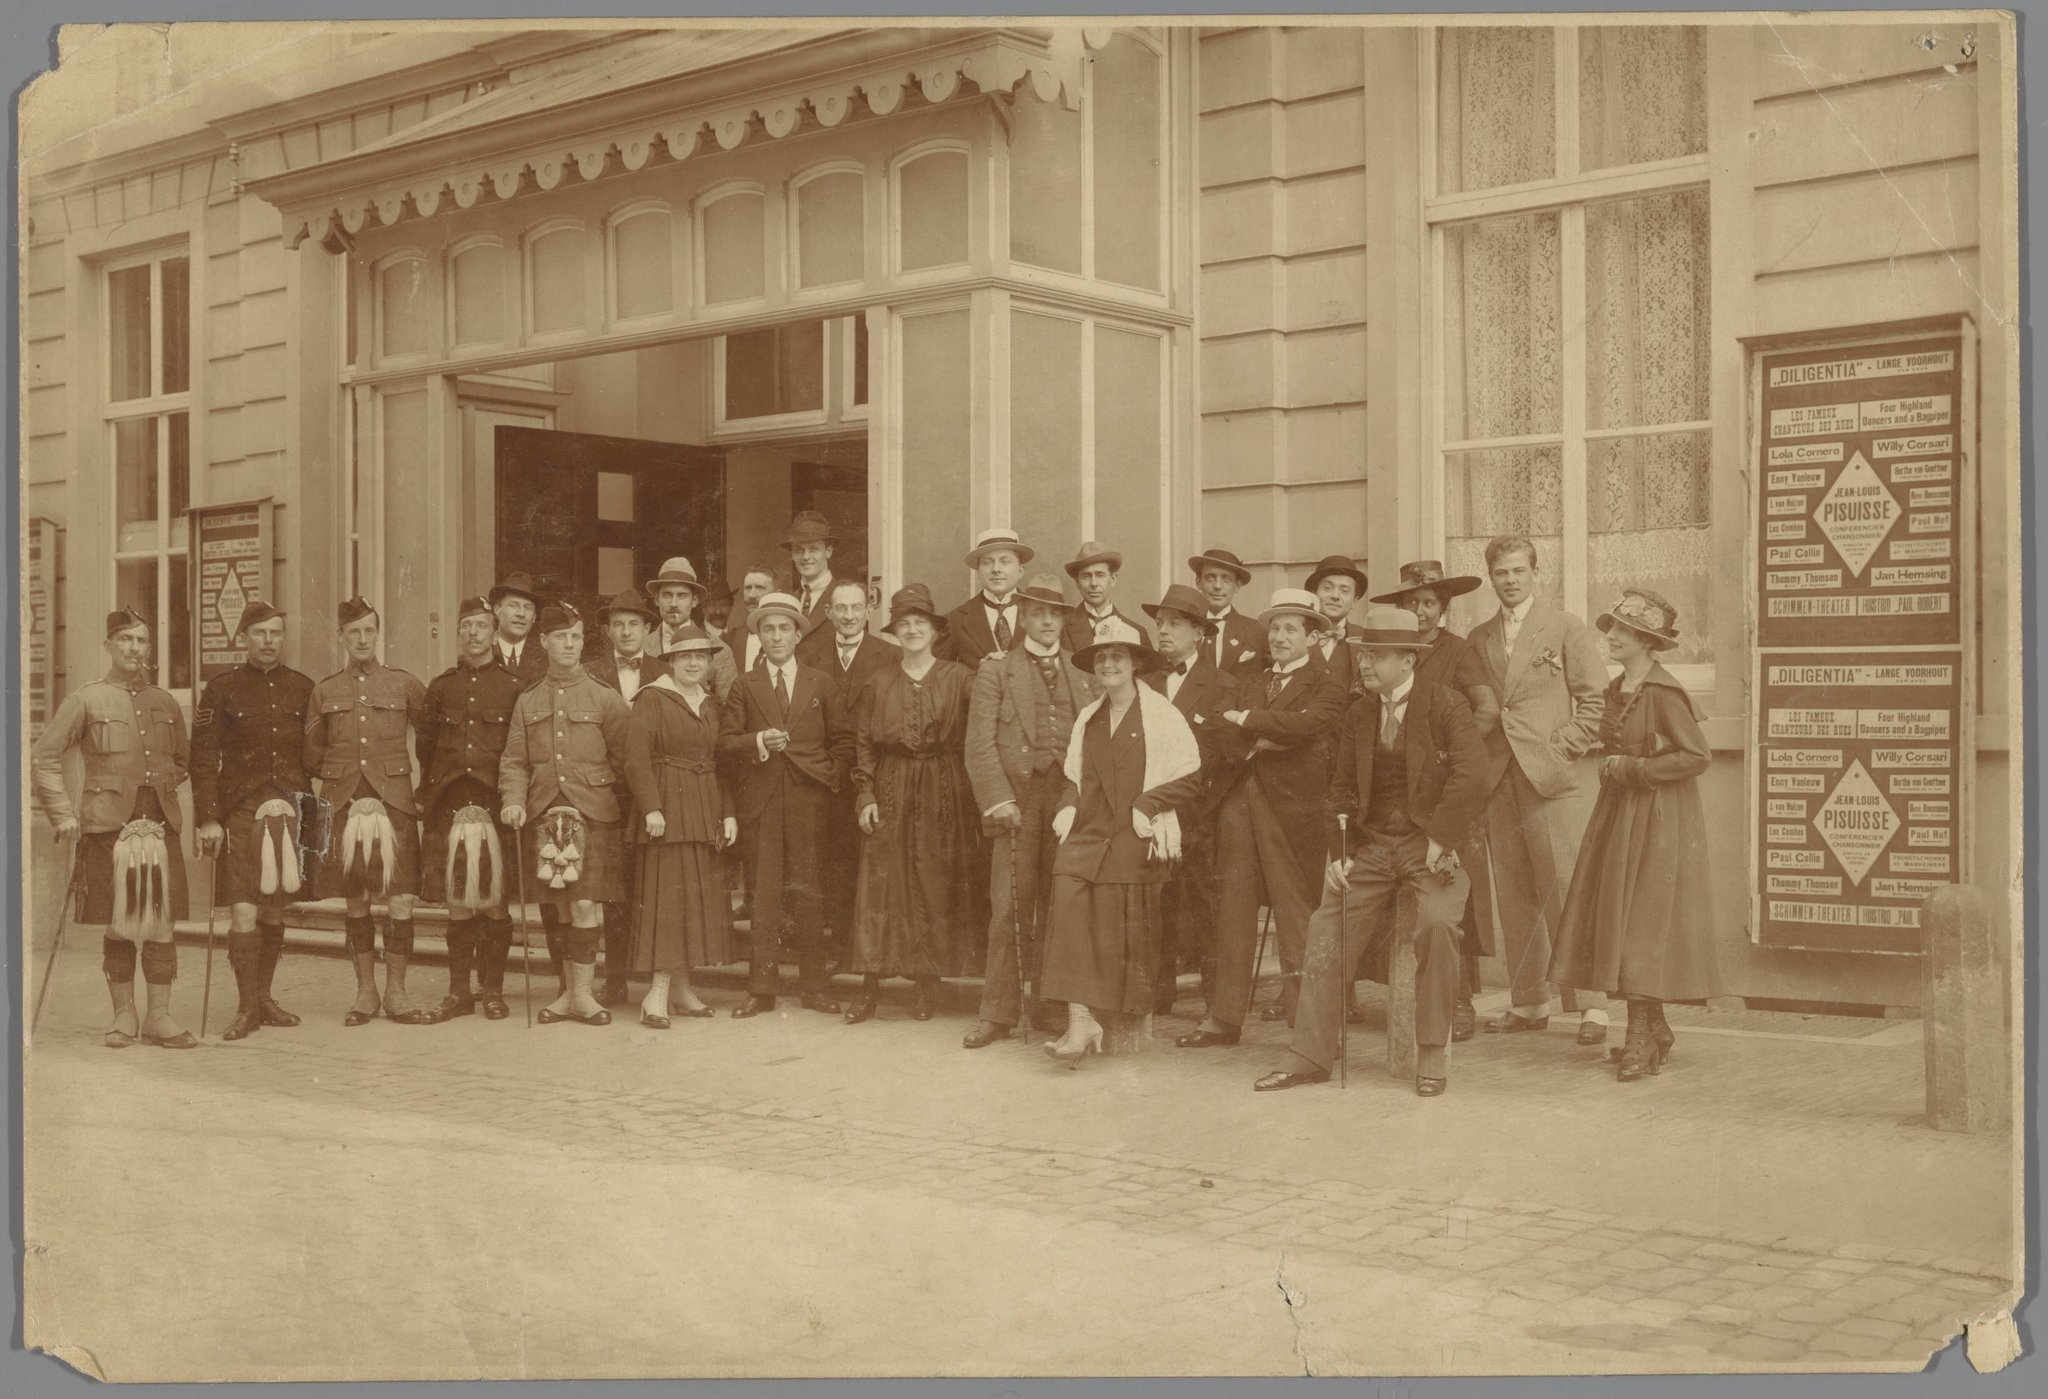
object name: photograph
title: Het Haagsche Cabaret en Schotse Hooglanders voor Diligentia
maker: Anonymous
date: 1900-1940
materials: photographic support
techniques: albumen print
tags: the hague